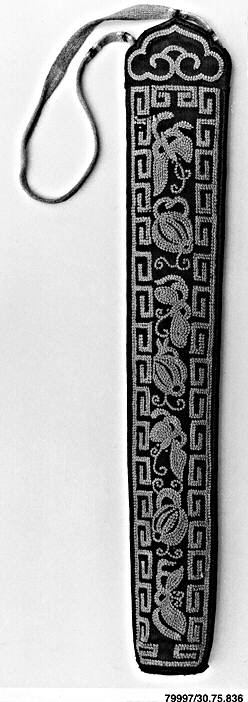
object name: fan holder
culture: chinese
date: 1701-1900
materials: silk